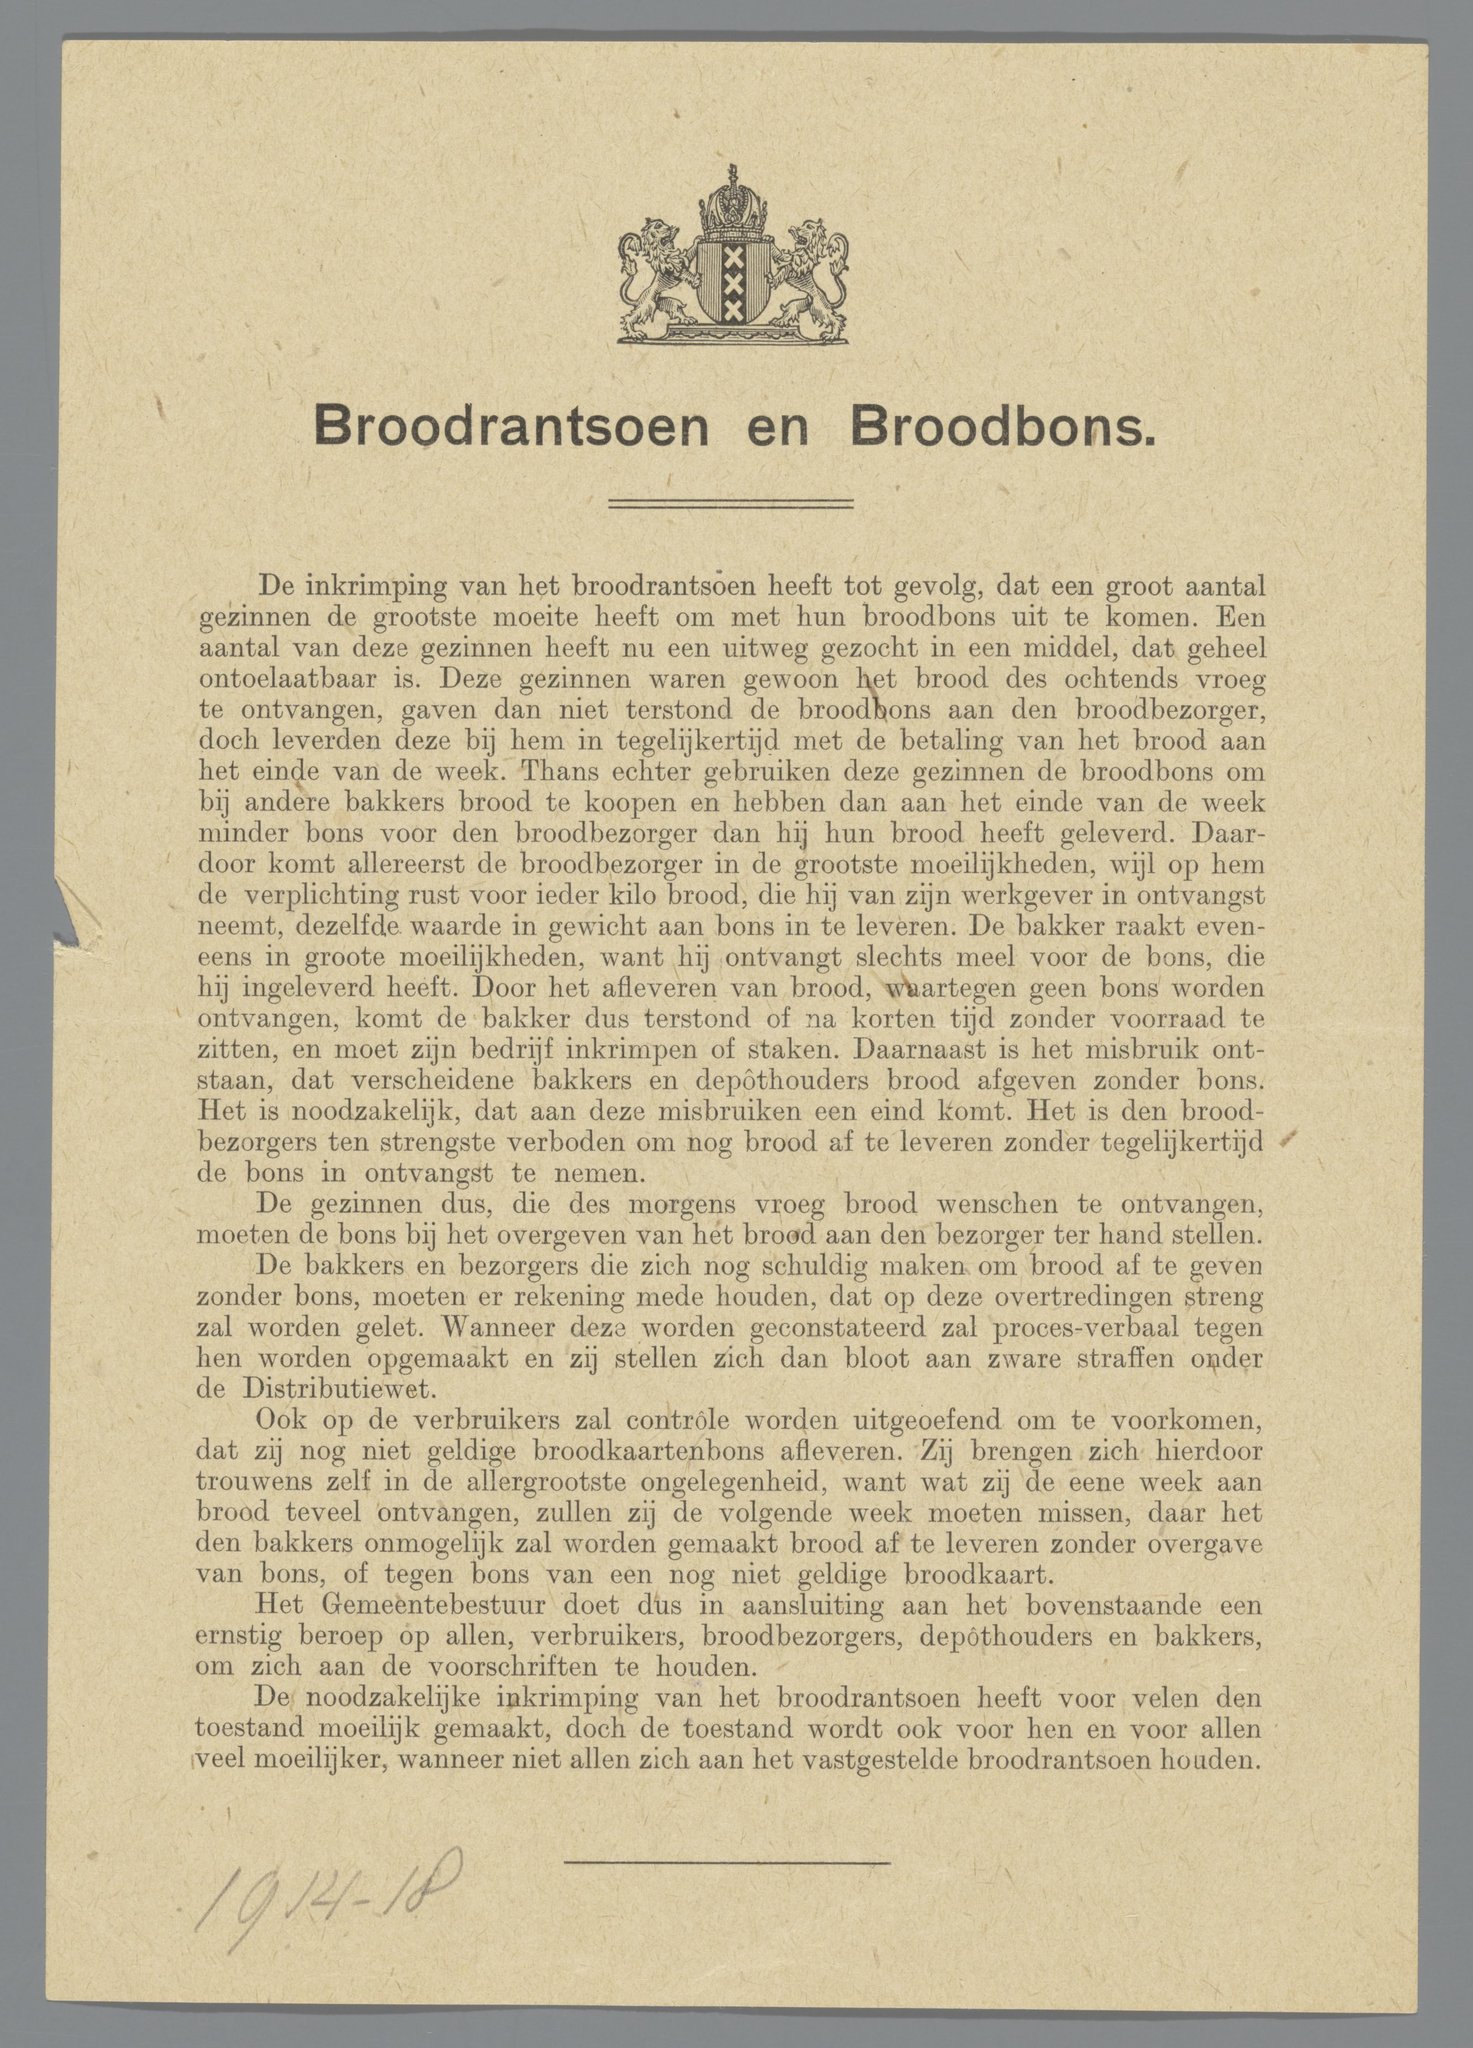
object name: document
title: Pamflet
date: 1914-1918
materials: paper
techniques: printing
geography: amsterdam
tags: amsterdam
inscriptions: date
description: Eénzijdig bedrukte pamflet. Gemerkt: wapen van Amsterdam.